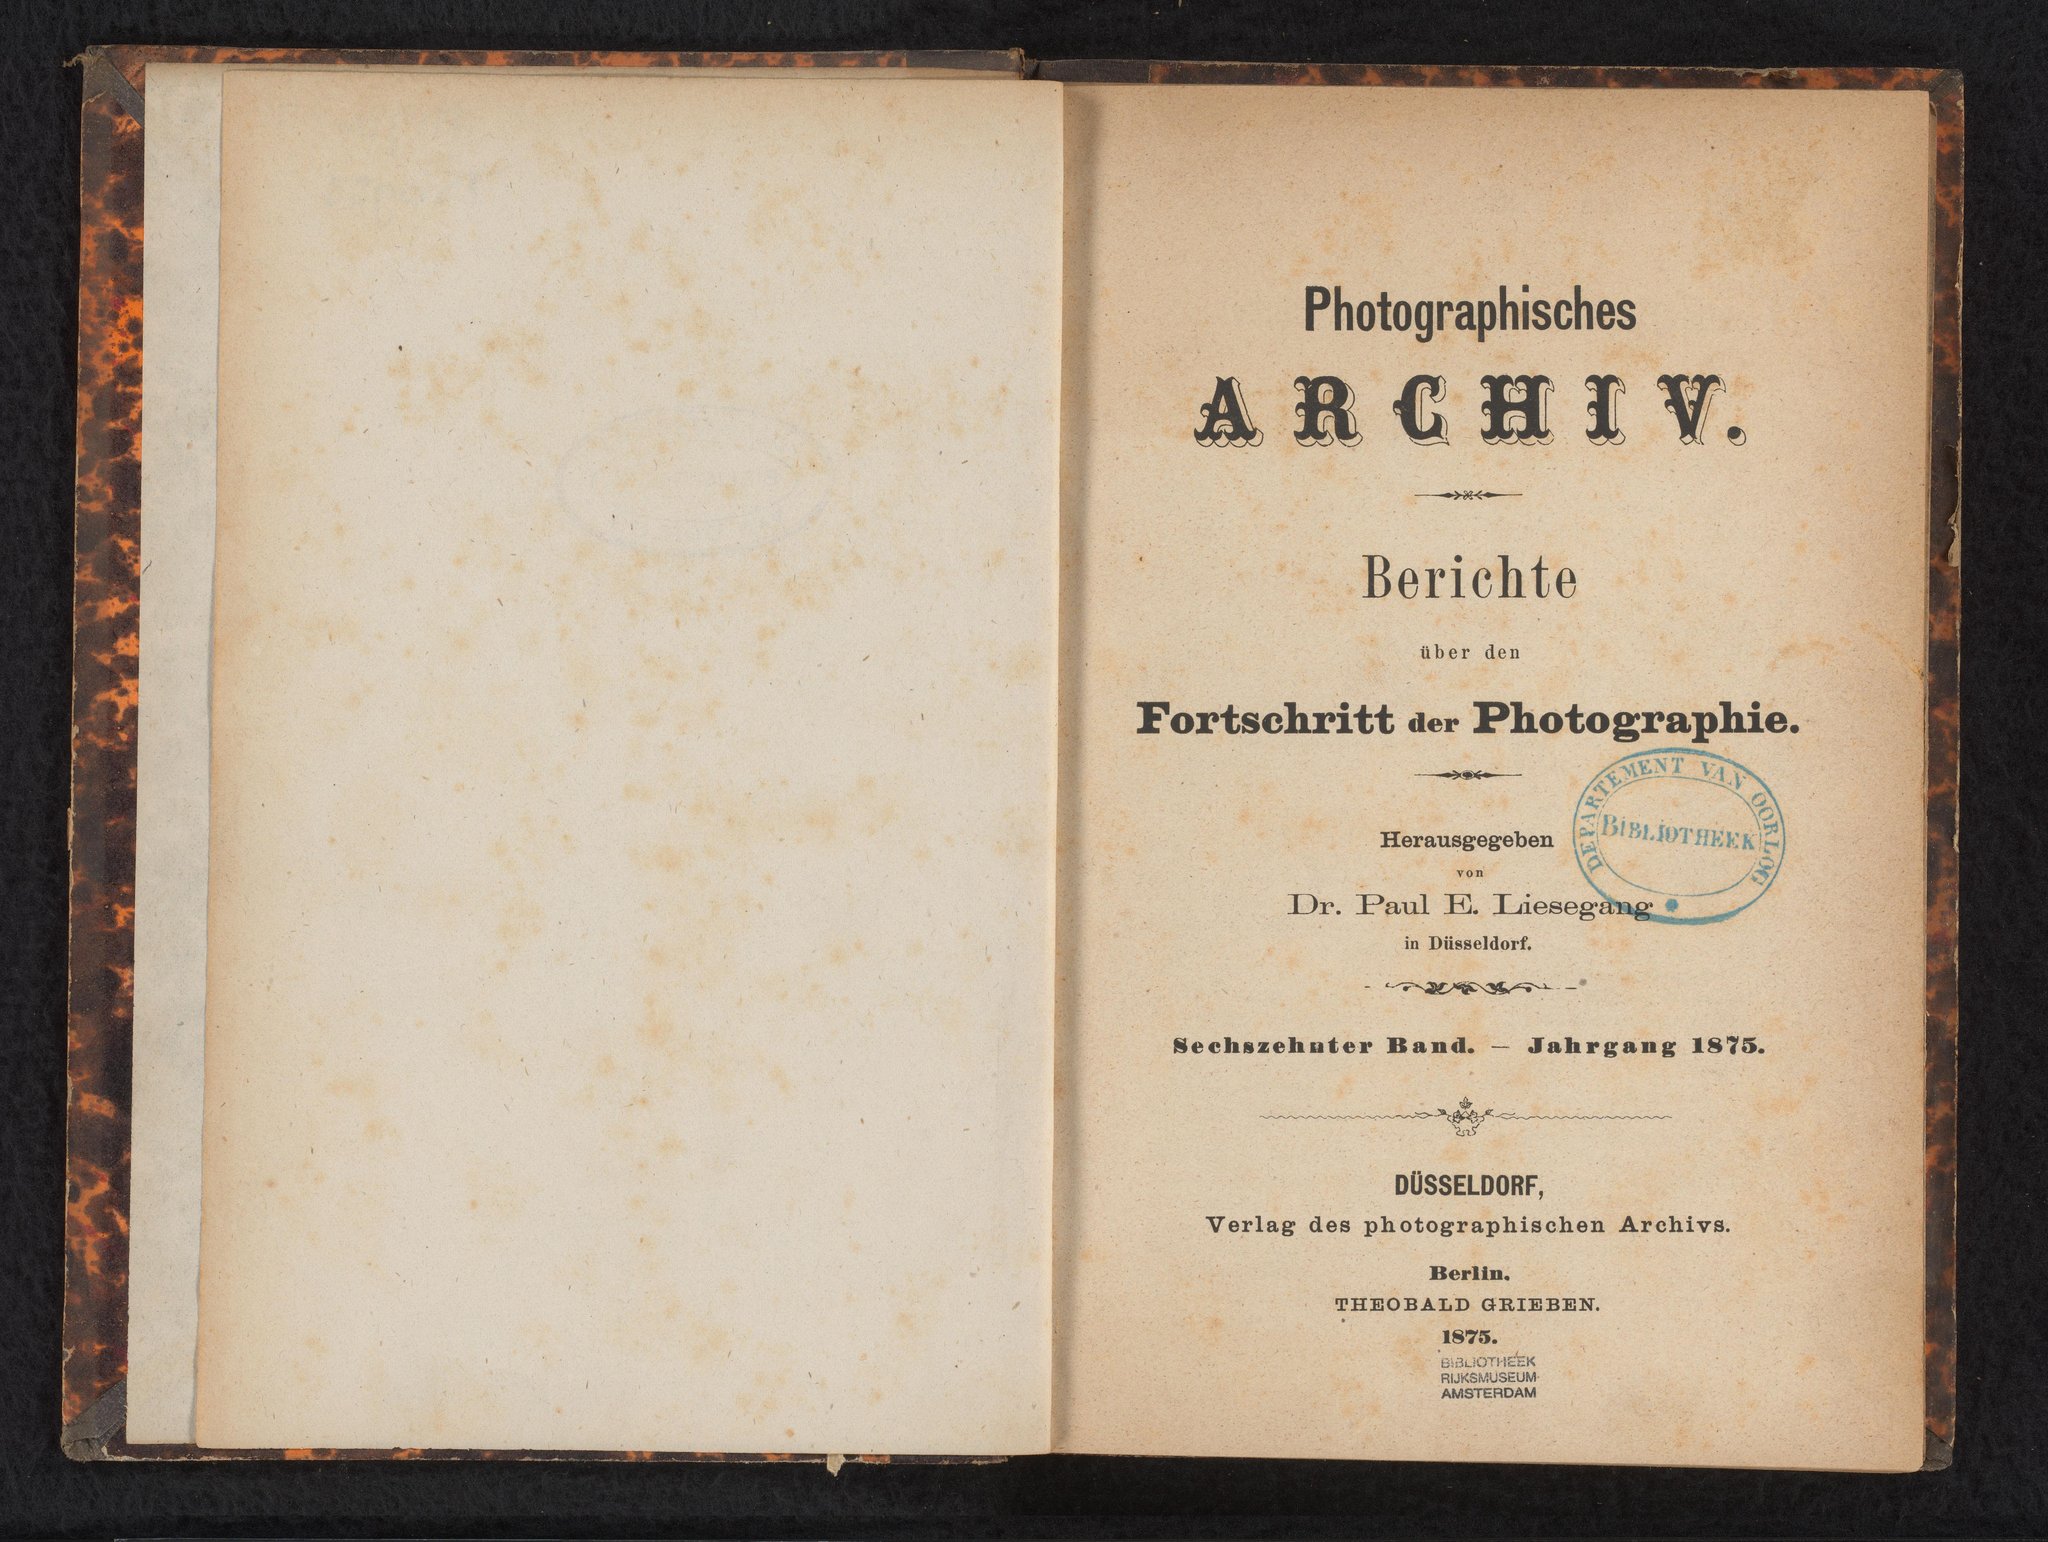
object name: book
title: Photographisches Archiv. Sechszehnter Band - Jahrgang 1875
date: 1875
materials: cardboard, leather, paper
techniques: photograph, engraving, letterpress printing, marbling, photolithography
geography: berlin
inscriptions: stamp: ‘Departement/ Bibliotheek/ van oorlog.’, stamp: ‘Departement van oorlog/ Bibliotheek’